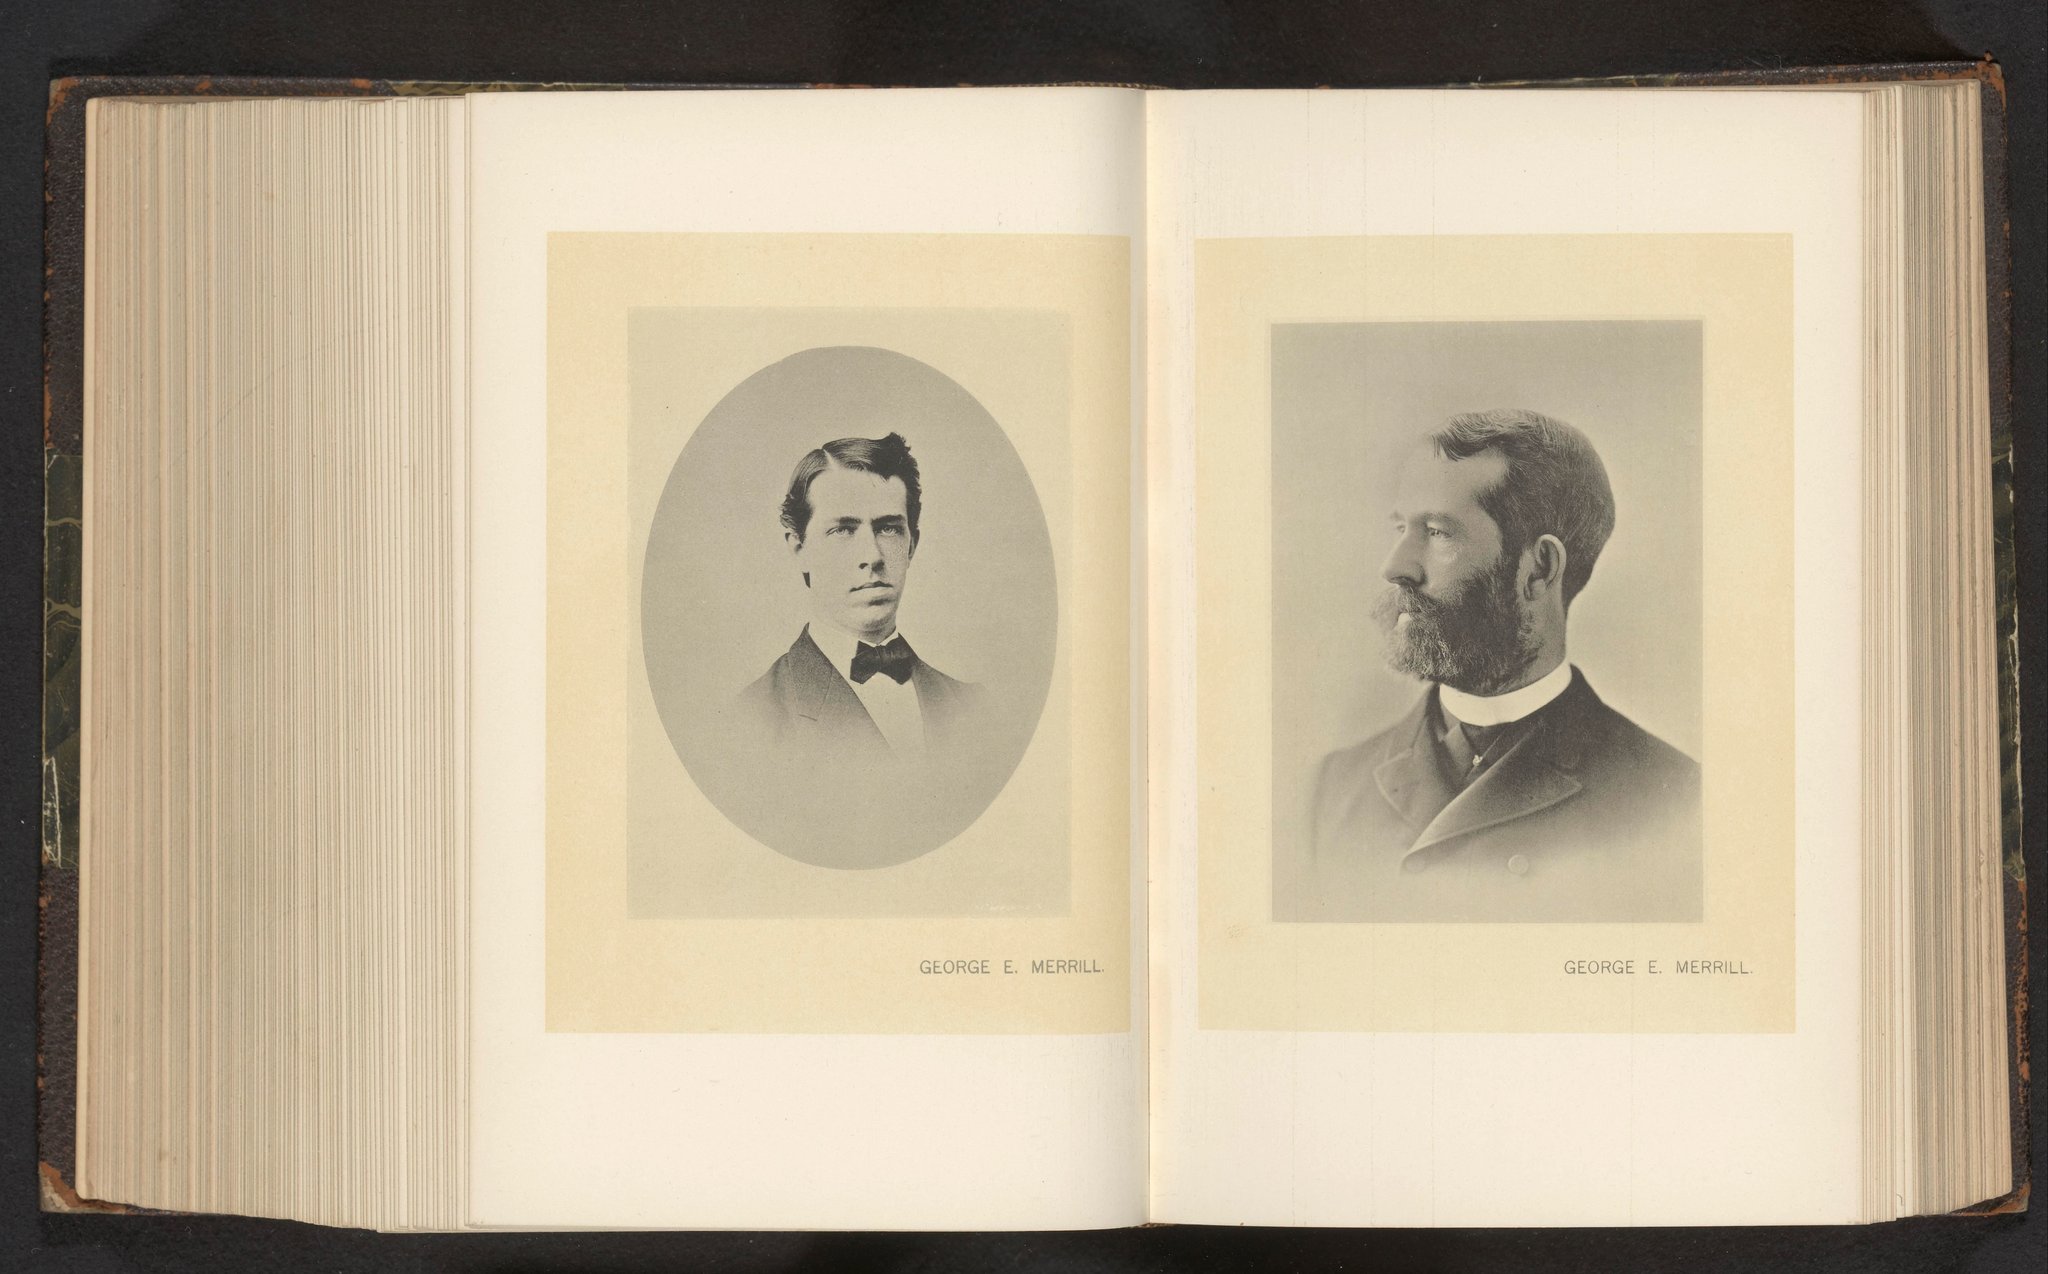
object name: photomechanical print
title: George E. Merrill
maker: Anonymous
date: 1889-1894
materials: paper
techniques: photoaquatint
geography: boston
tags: adult man